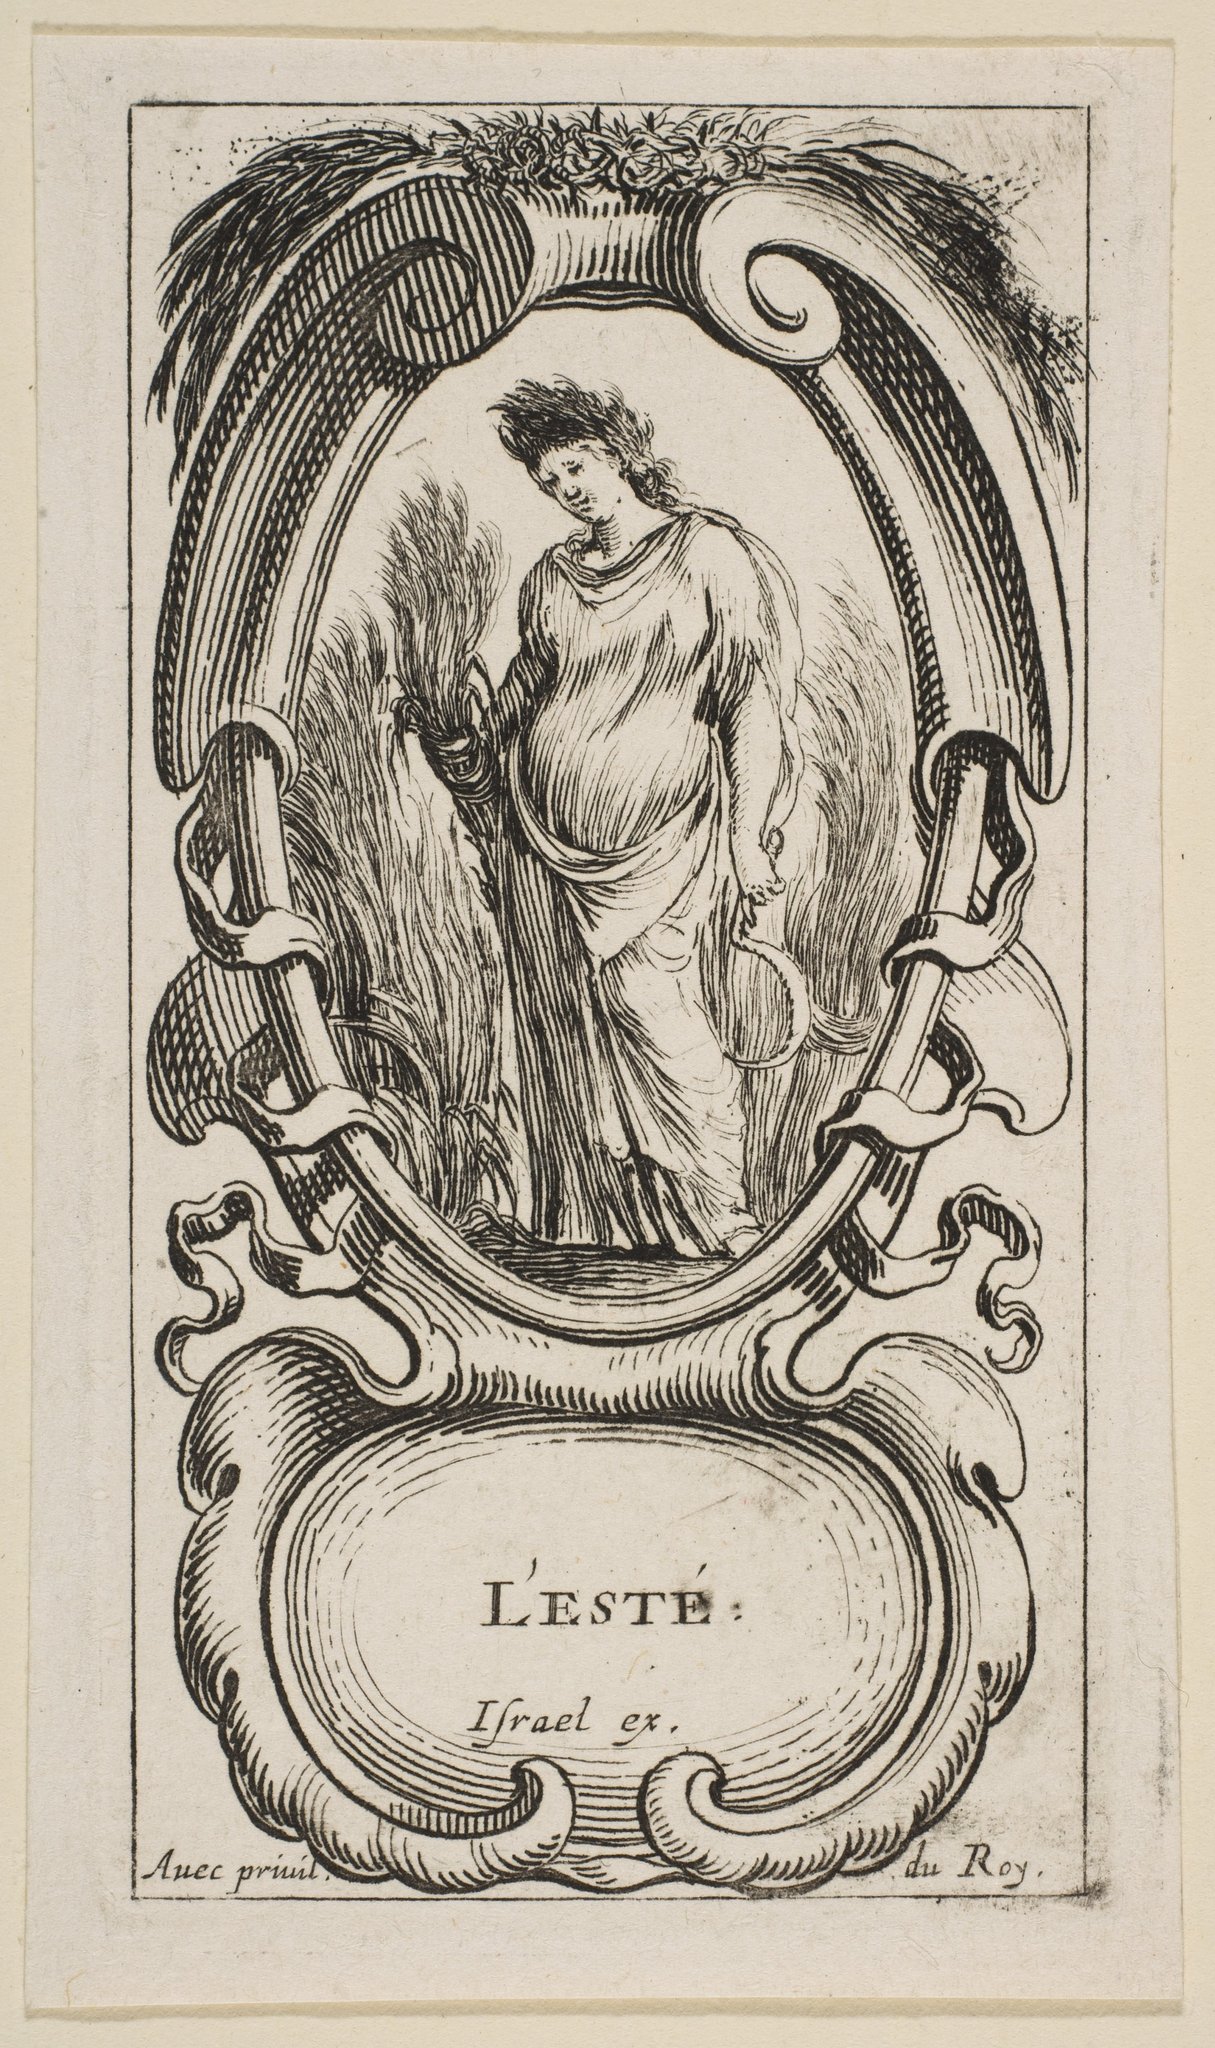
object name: print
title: Summer (L'Eté), from 'The Four Seasons'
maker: stefano della bella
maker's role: artist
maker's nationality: italian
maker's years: 1610-1664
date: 1641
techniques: etching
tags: women,summer